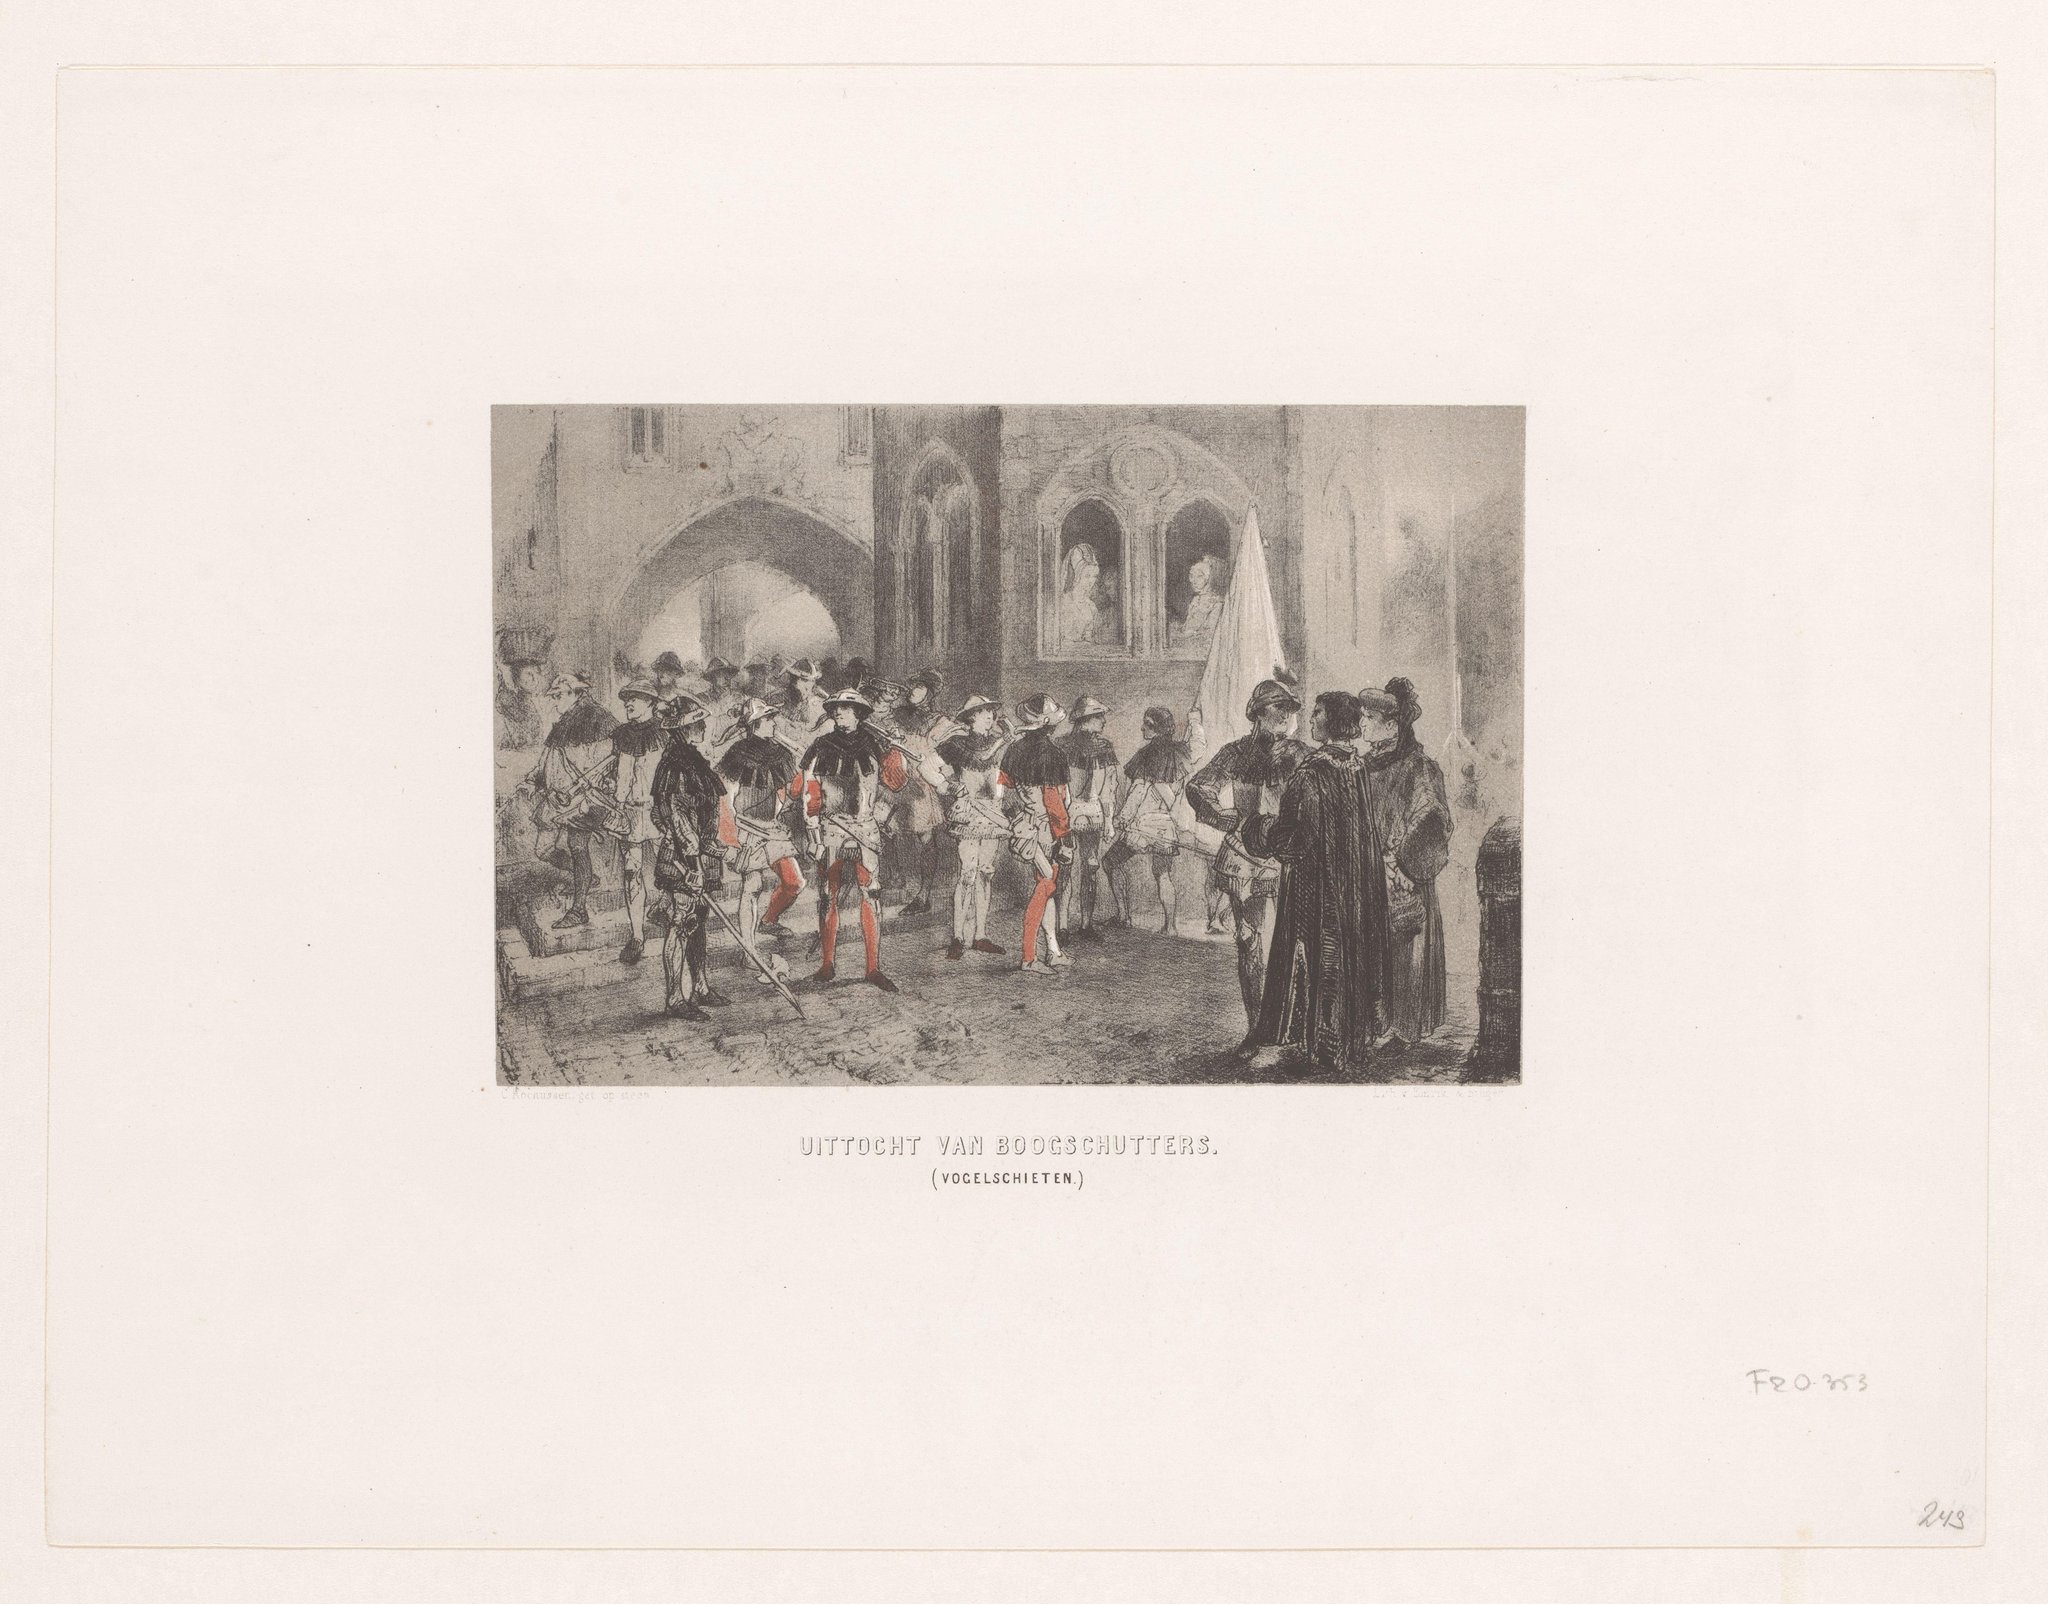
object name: print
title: Uittocht van boogschutters (vogelschieten)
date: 1858-1864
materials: paper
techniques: hand coloring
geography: haarlem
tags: shooting with bow and arrow, archery (~ games of skill)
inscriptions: collector's mark: Lugt 2228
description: Prent uit: Hofdijk, W.F. Ons voorgeslacht in zijn dagelijksch leven geschilderd. Haarlem: Kruseman, Arie Cornelis, 1858-1864.